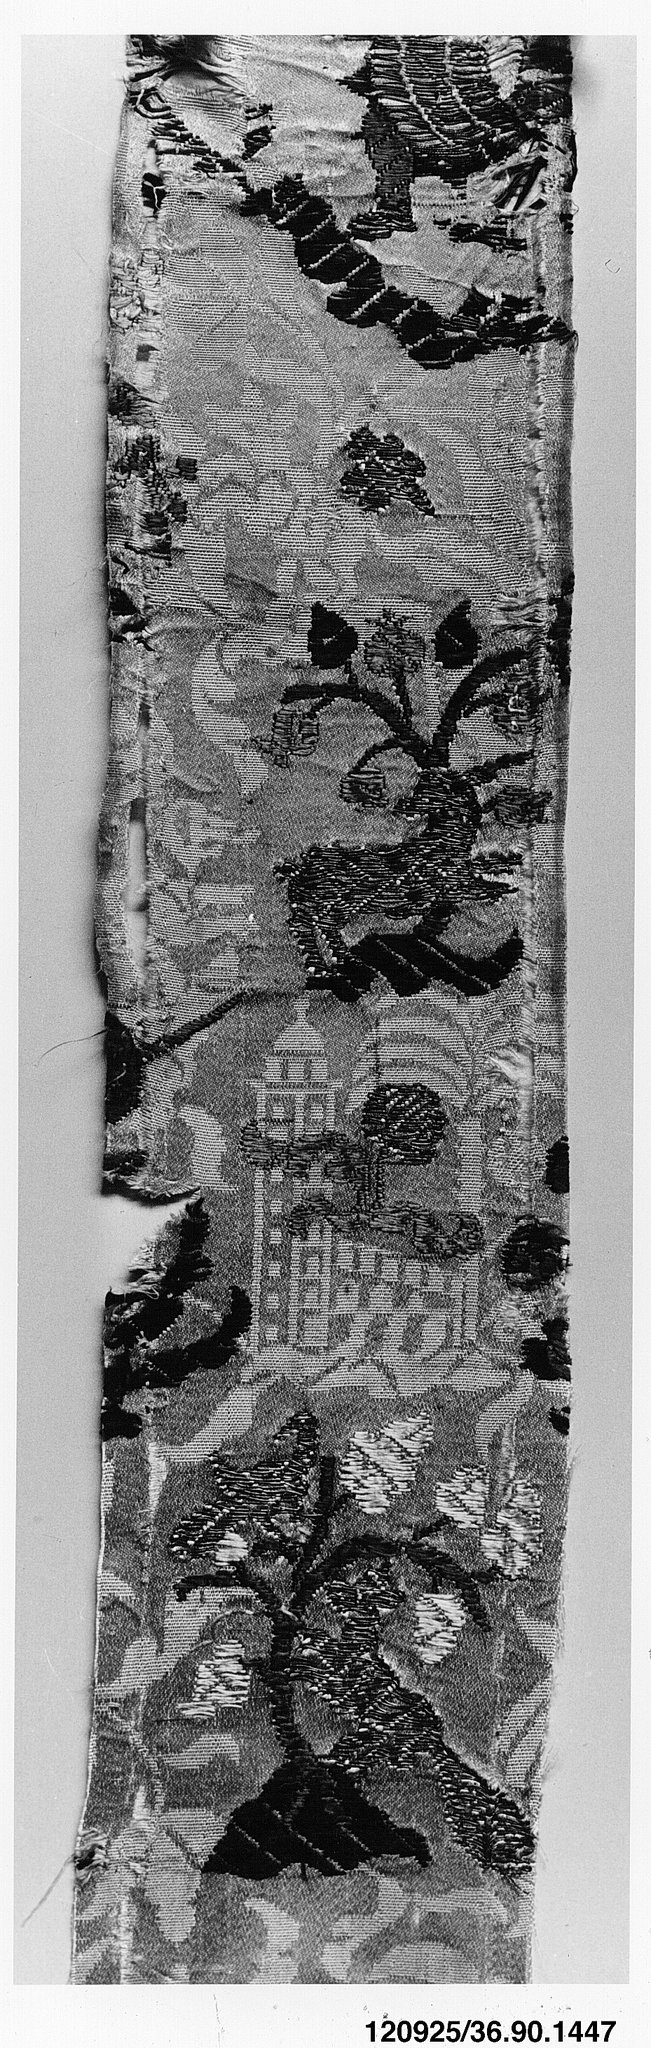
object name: piece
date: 1700-1715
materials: silk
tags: animals,birds,leaves